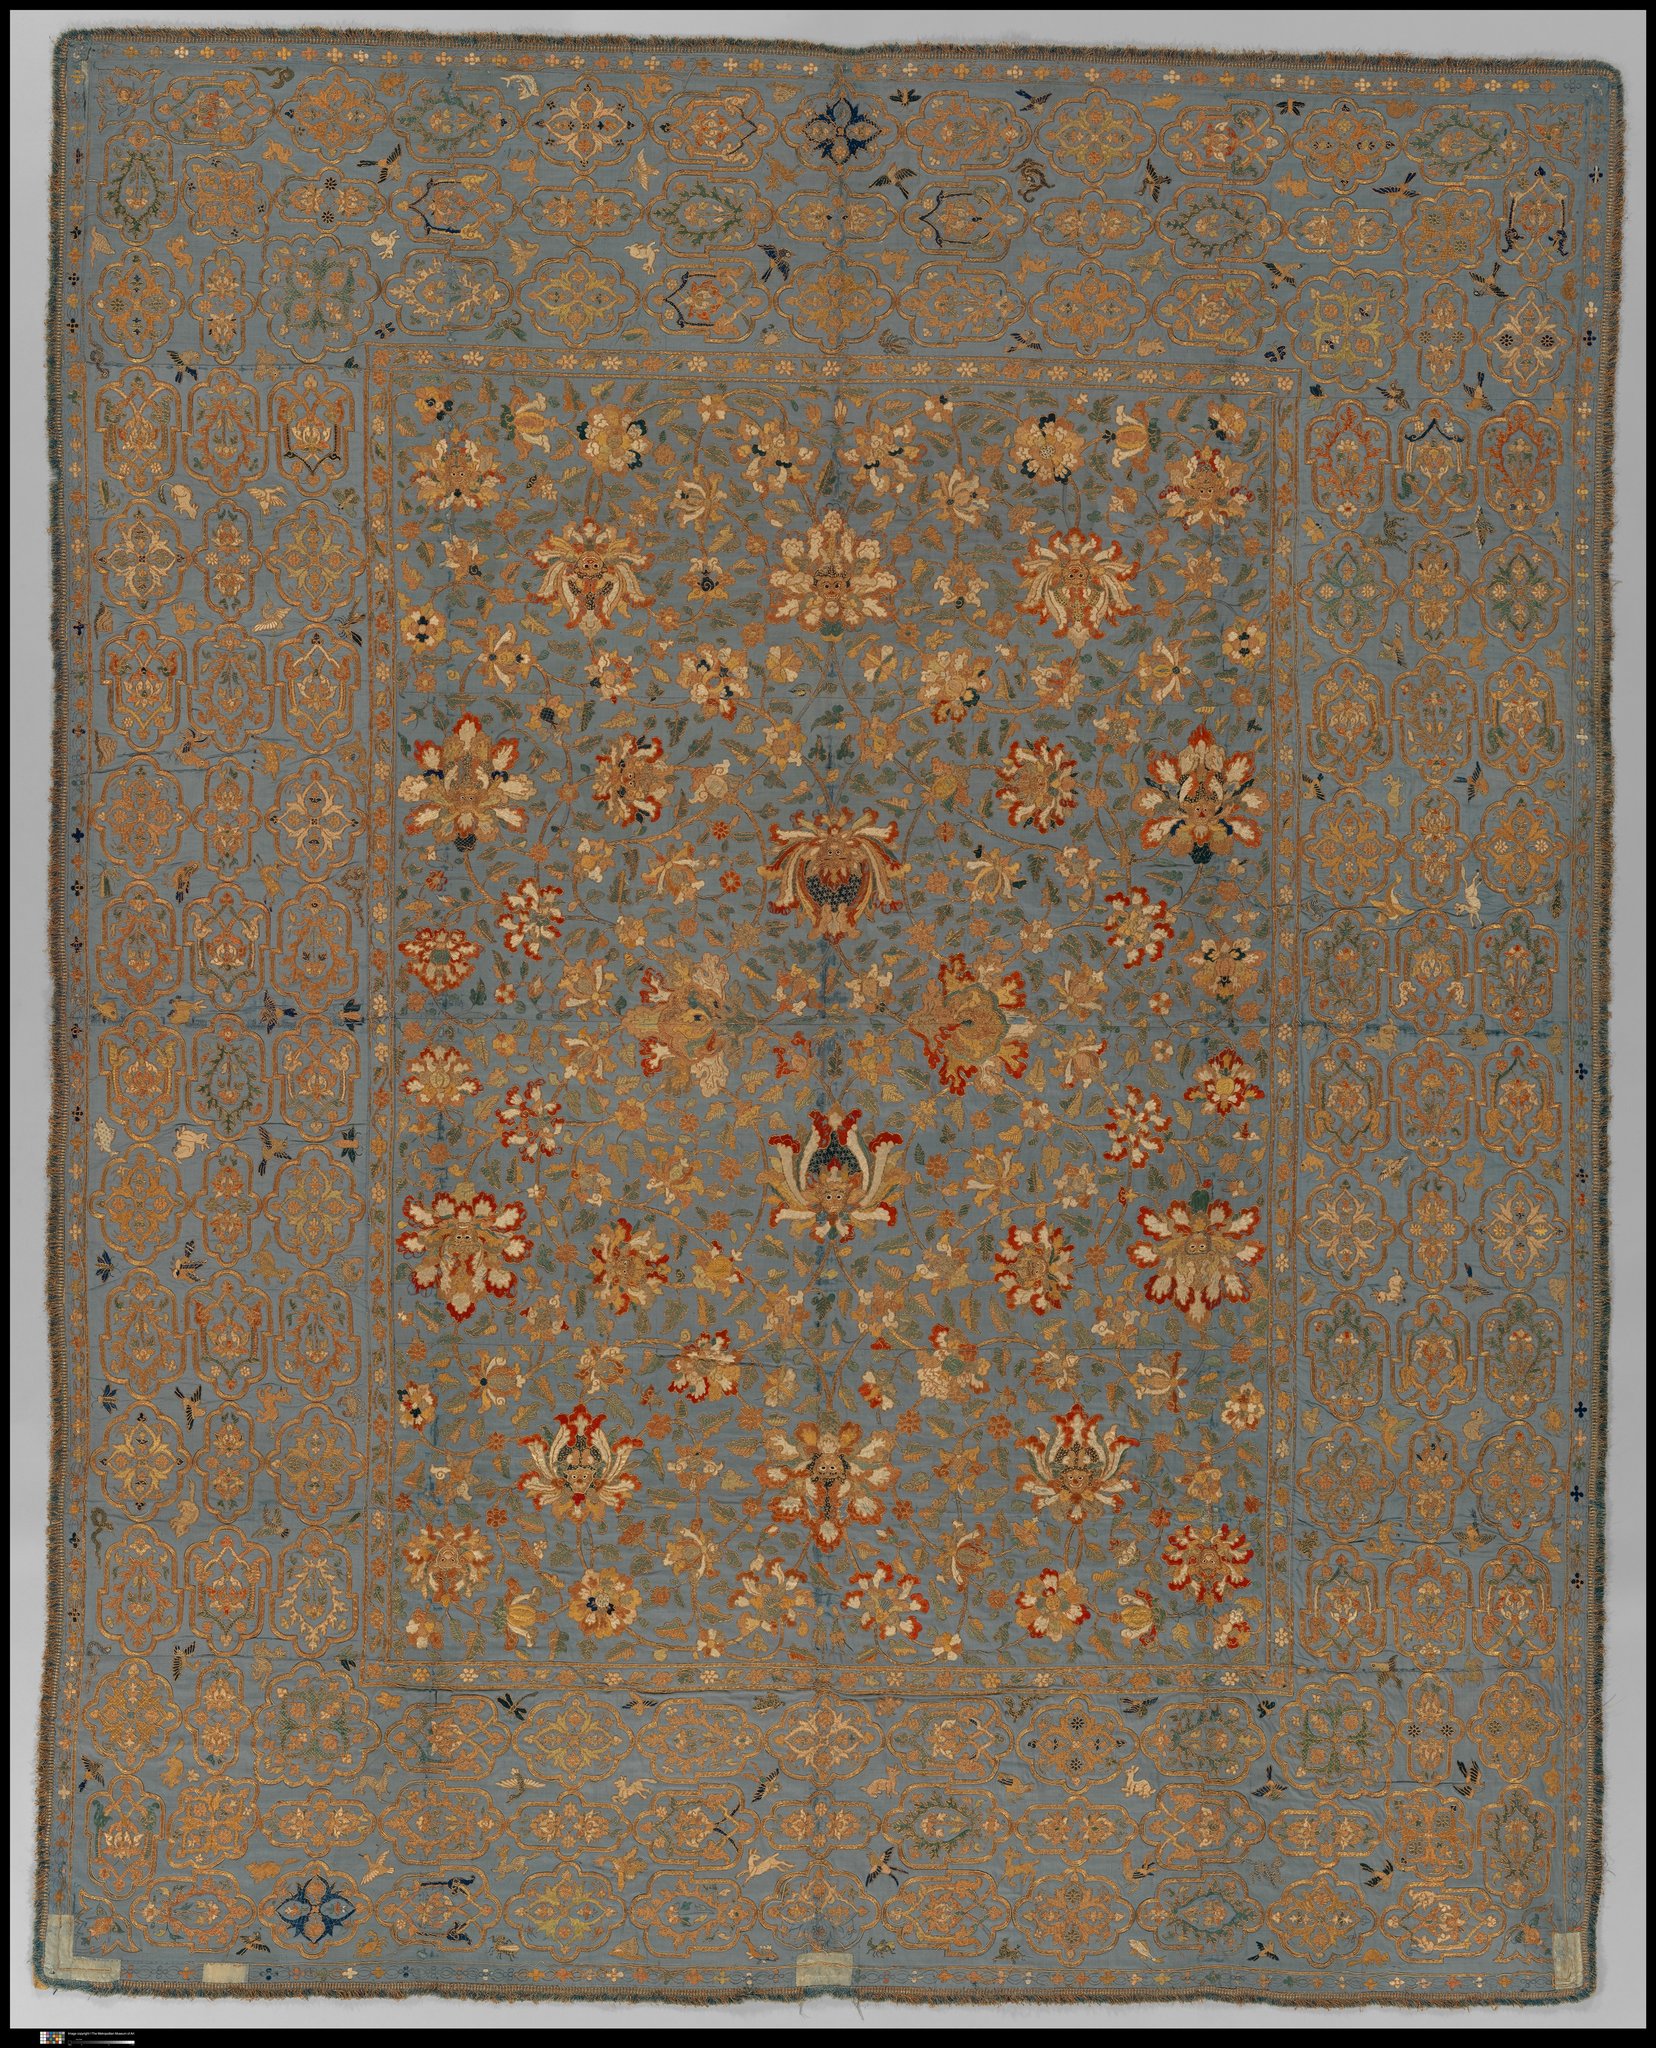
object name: furniture cover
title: Furniture Cover for Table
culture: chinese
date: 1601-1700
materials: cotton, metal thread, silk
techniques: embroidery, weave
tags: flowers